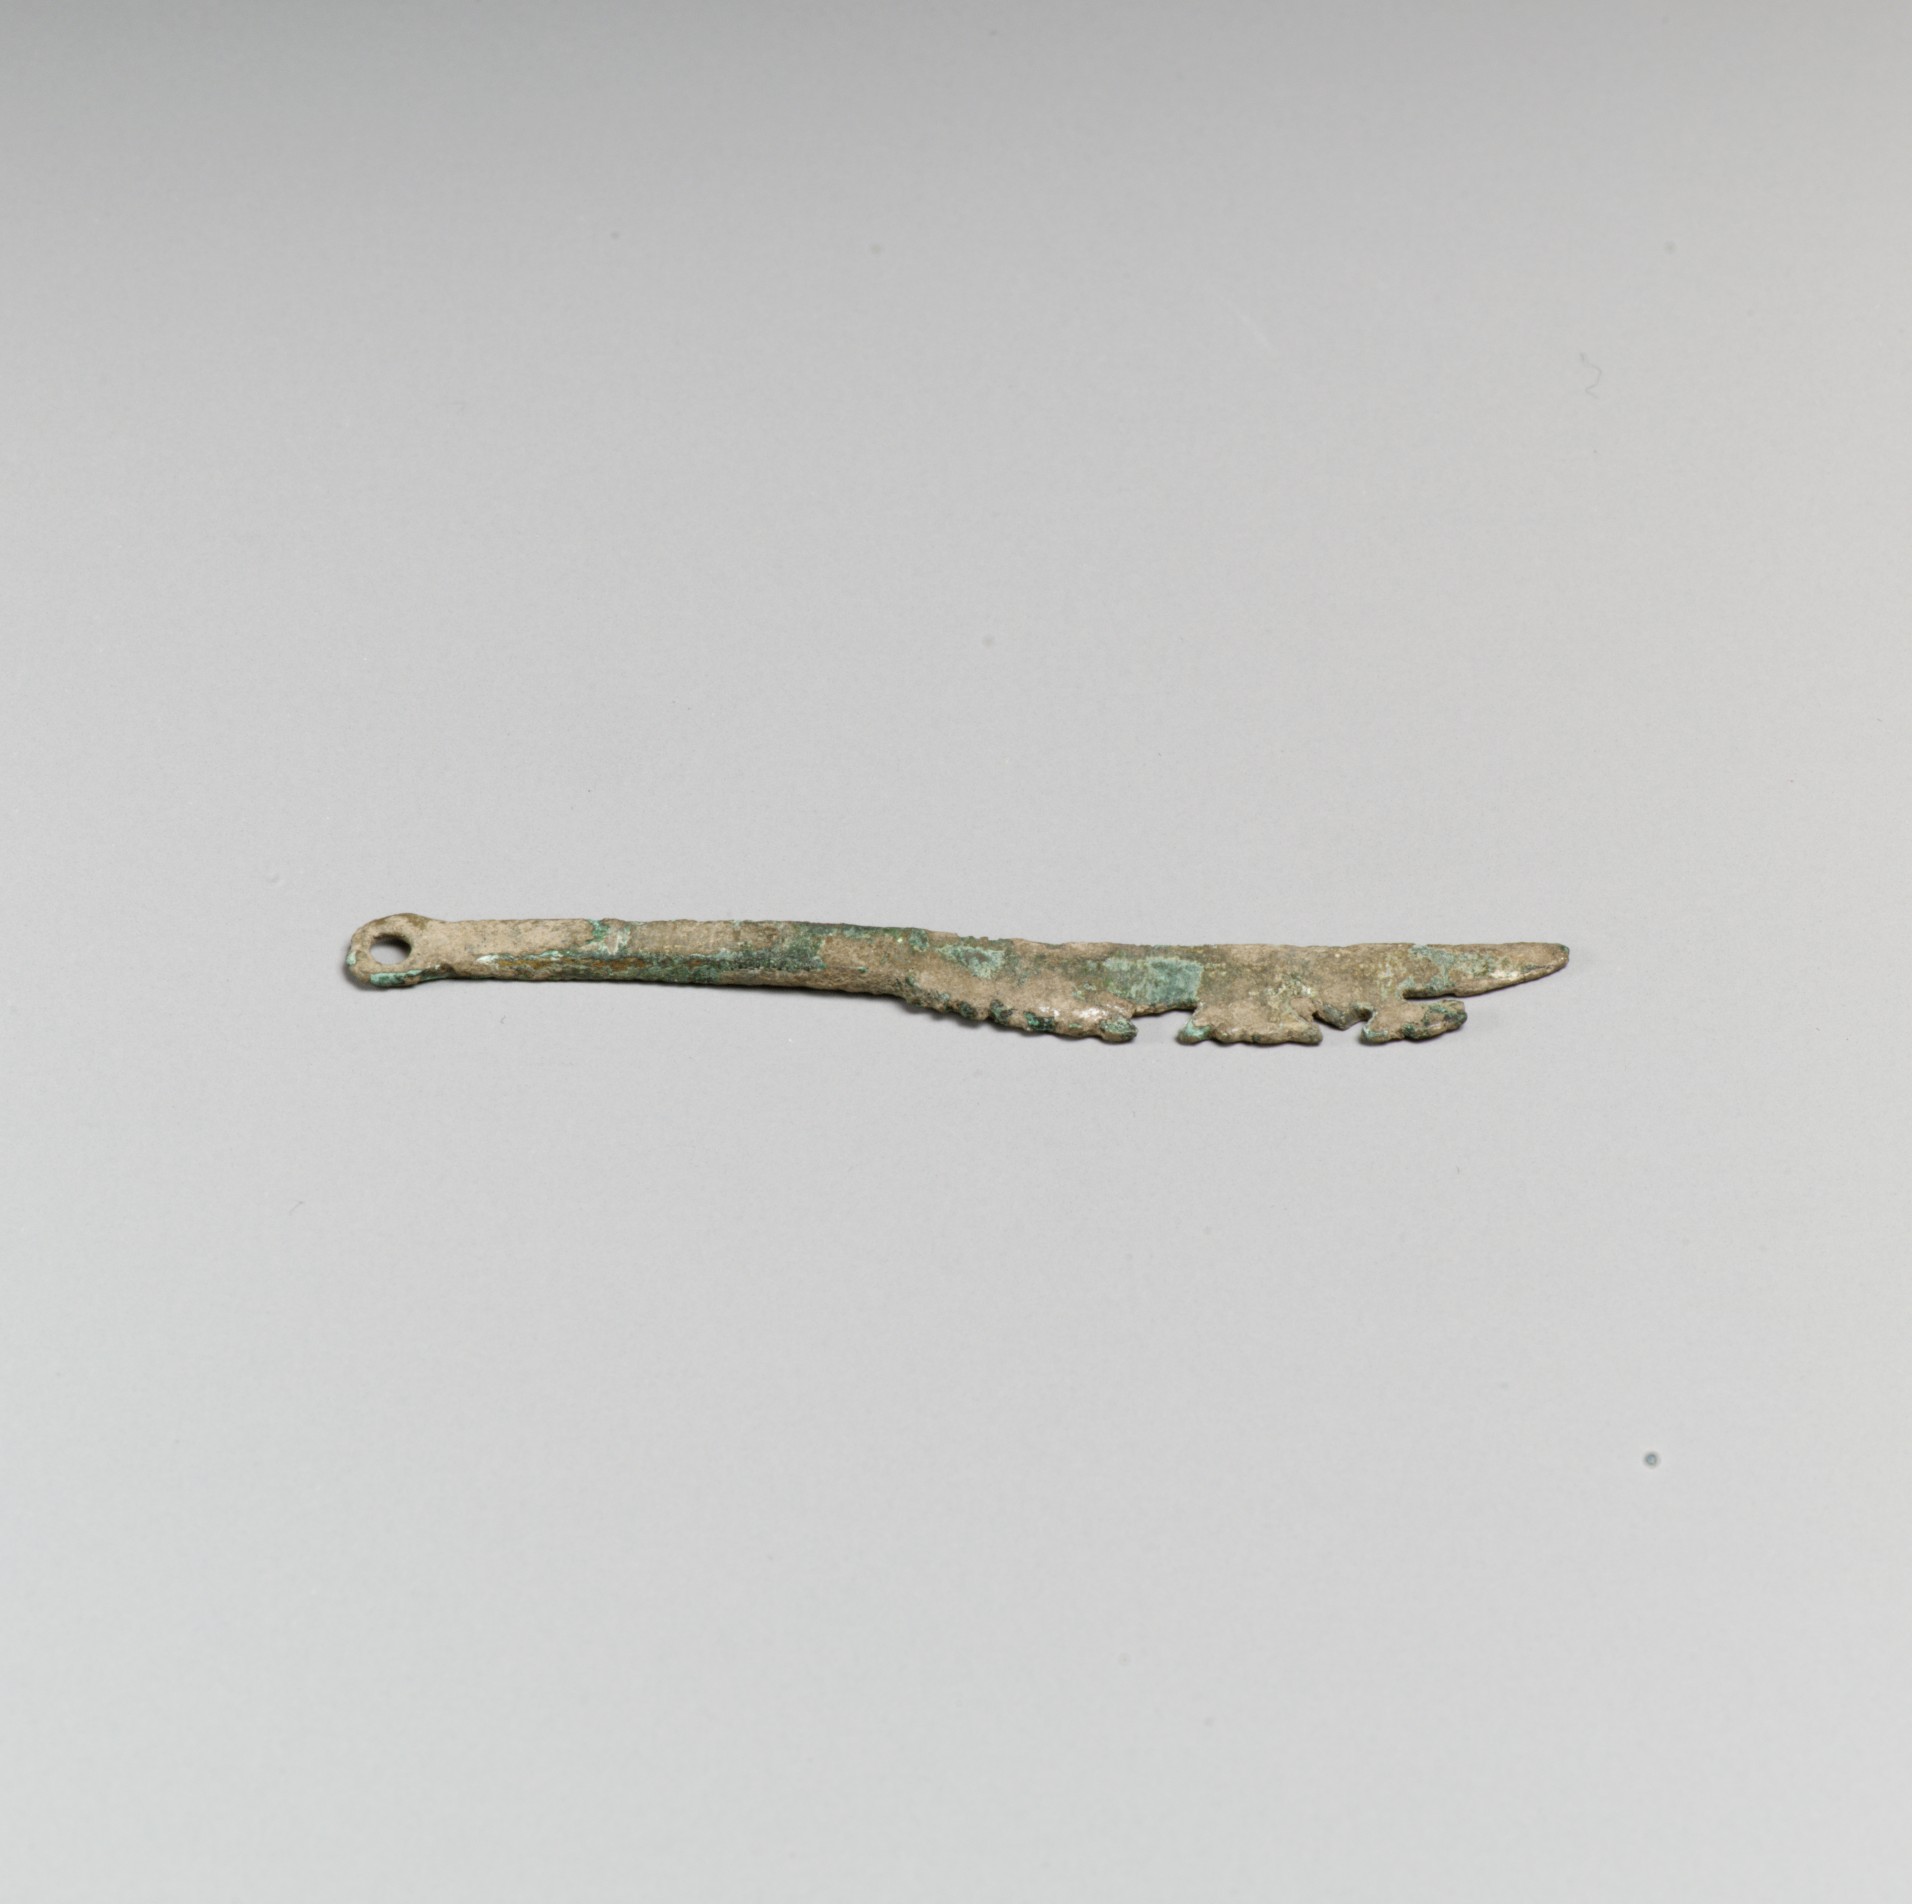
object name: knife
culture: roman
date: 670 BCE-330 CE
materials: bronze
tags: knives